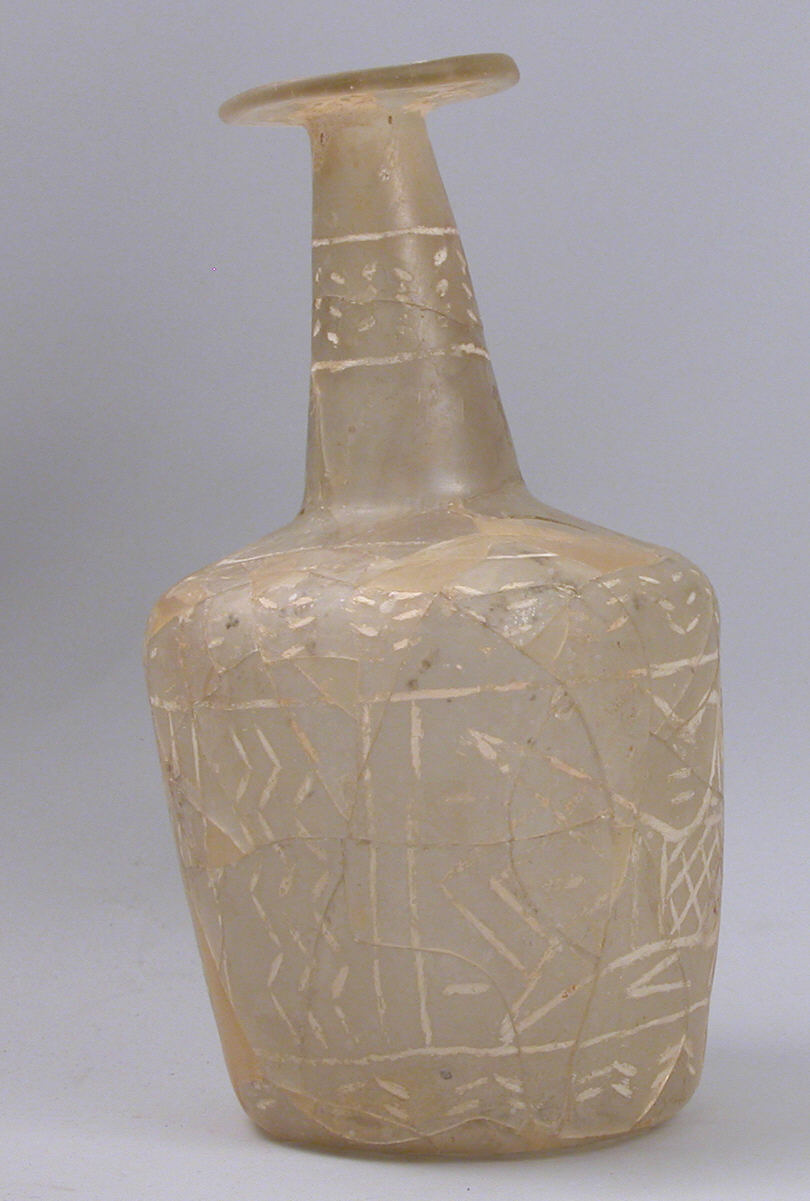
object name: bottle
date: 901-1000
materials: glass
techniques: cutting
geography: iran